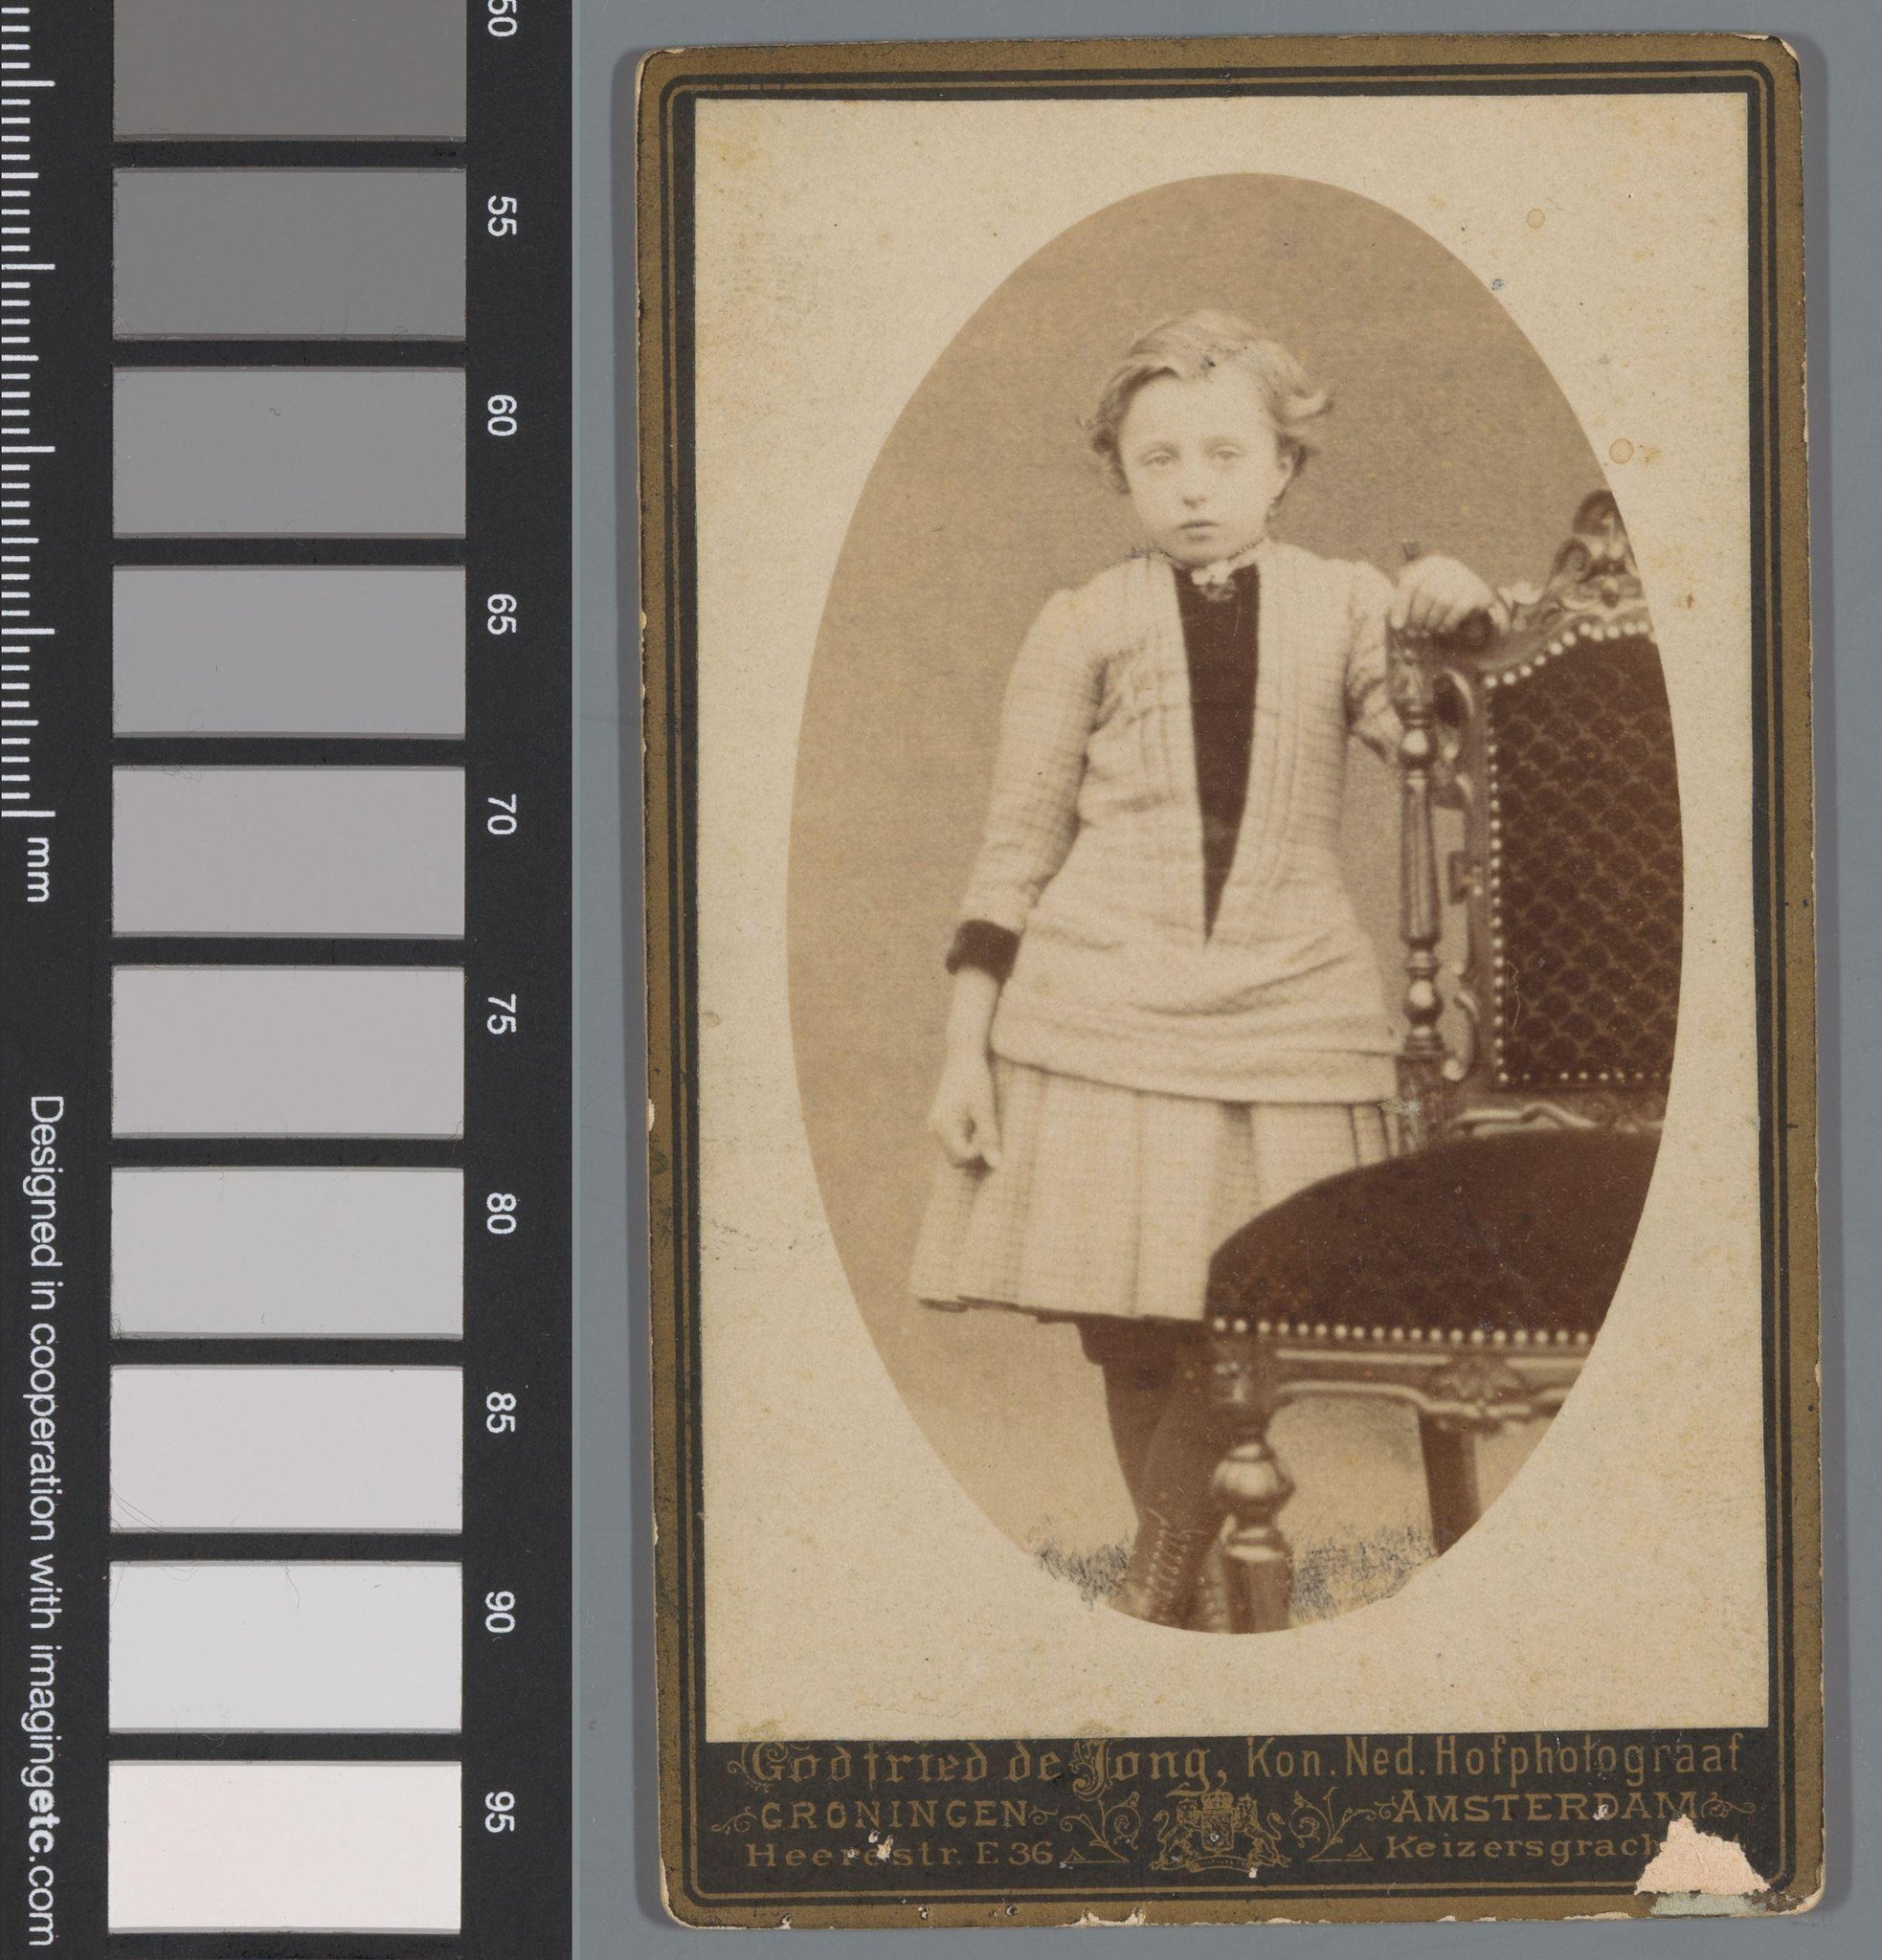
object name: carte de visite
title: Portret van Tine Boerma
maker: godfried de jong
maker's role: print maker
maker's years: 1832-1918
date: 1886-1896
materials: cardboard, paper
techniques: albumen print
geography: amsterdam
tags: historical persons, girl (child between toddler and youth), amsterdam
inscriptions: inscription: ‘Bekroond op de/ Internationale Tentoonstelling/ te Amsterdam 1874 en 1883./ Godfried de Jong/ Photographe-Artiste/ van Z.M./ den Koning/der/ Nederlanden,/ en geoctroijeerd/ door/ Z.M. den Koning der Belgen/ Groningen/ en/ Amsterdam./ Van deze photographie kan nabesteld worden/ Vergrooting naar visitekaarten in alle afmetingen’, inscription: ‘Godfried de Jong, Kon. Ned. Hofphotograaf/ Groningen/ Amsterdam/ Heerestraat E36/ Keizersgrach[...]’, inscription: ‘Tine Boerma’